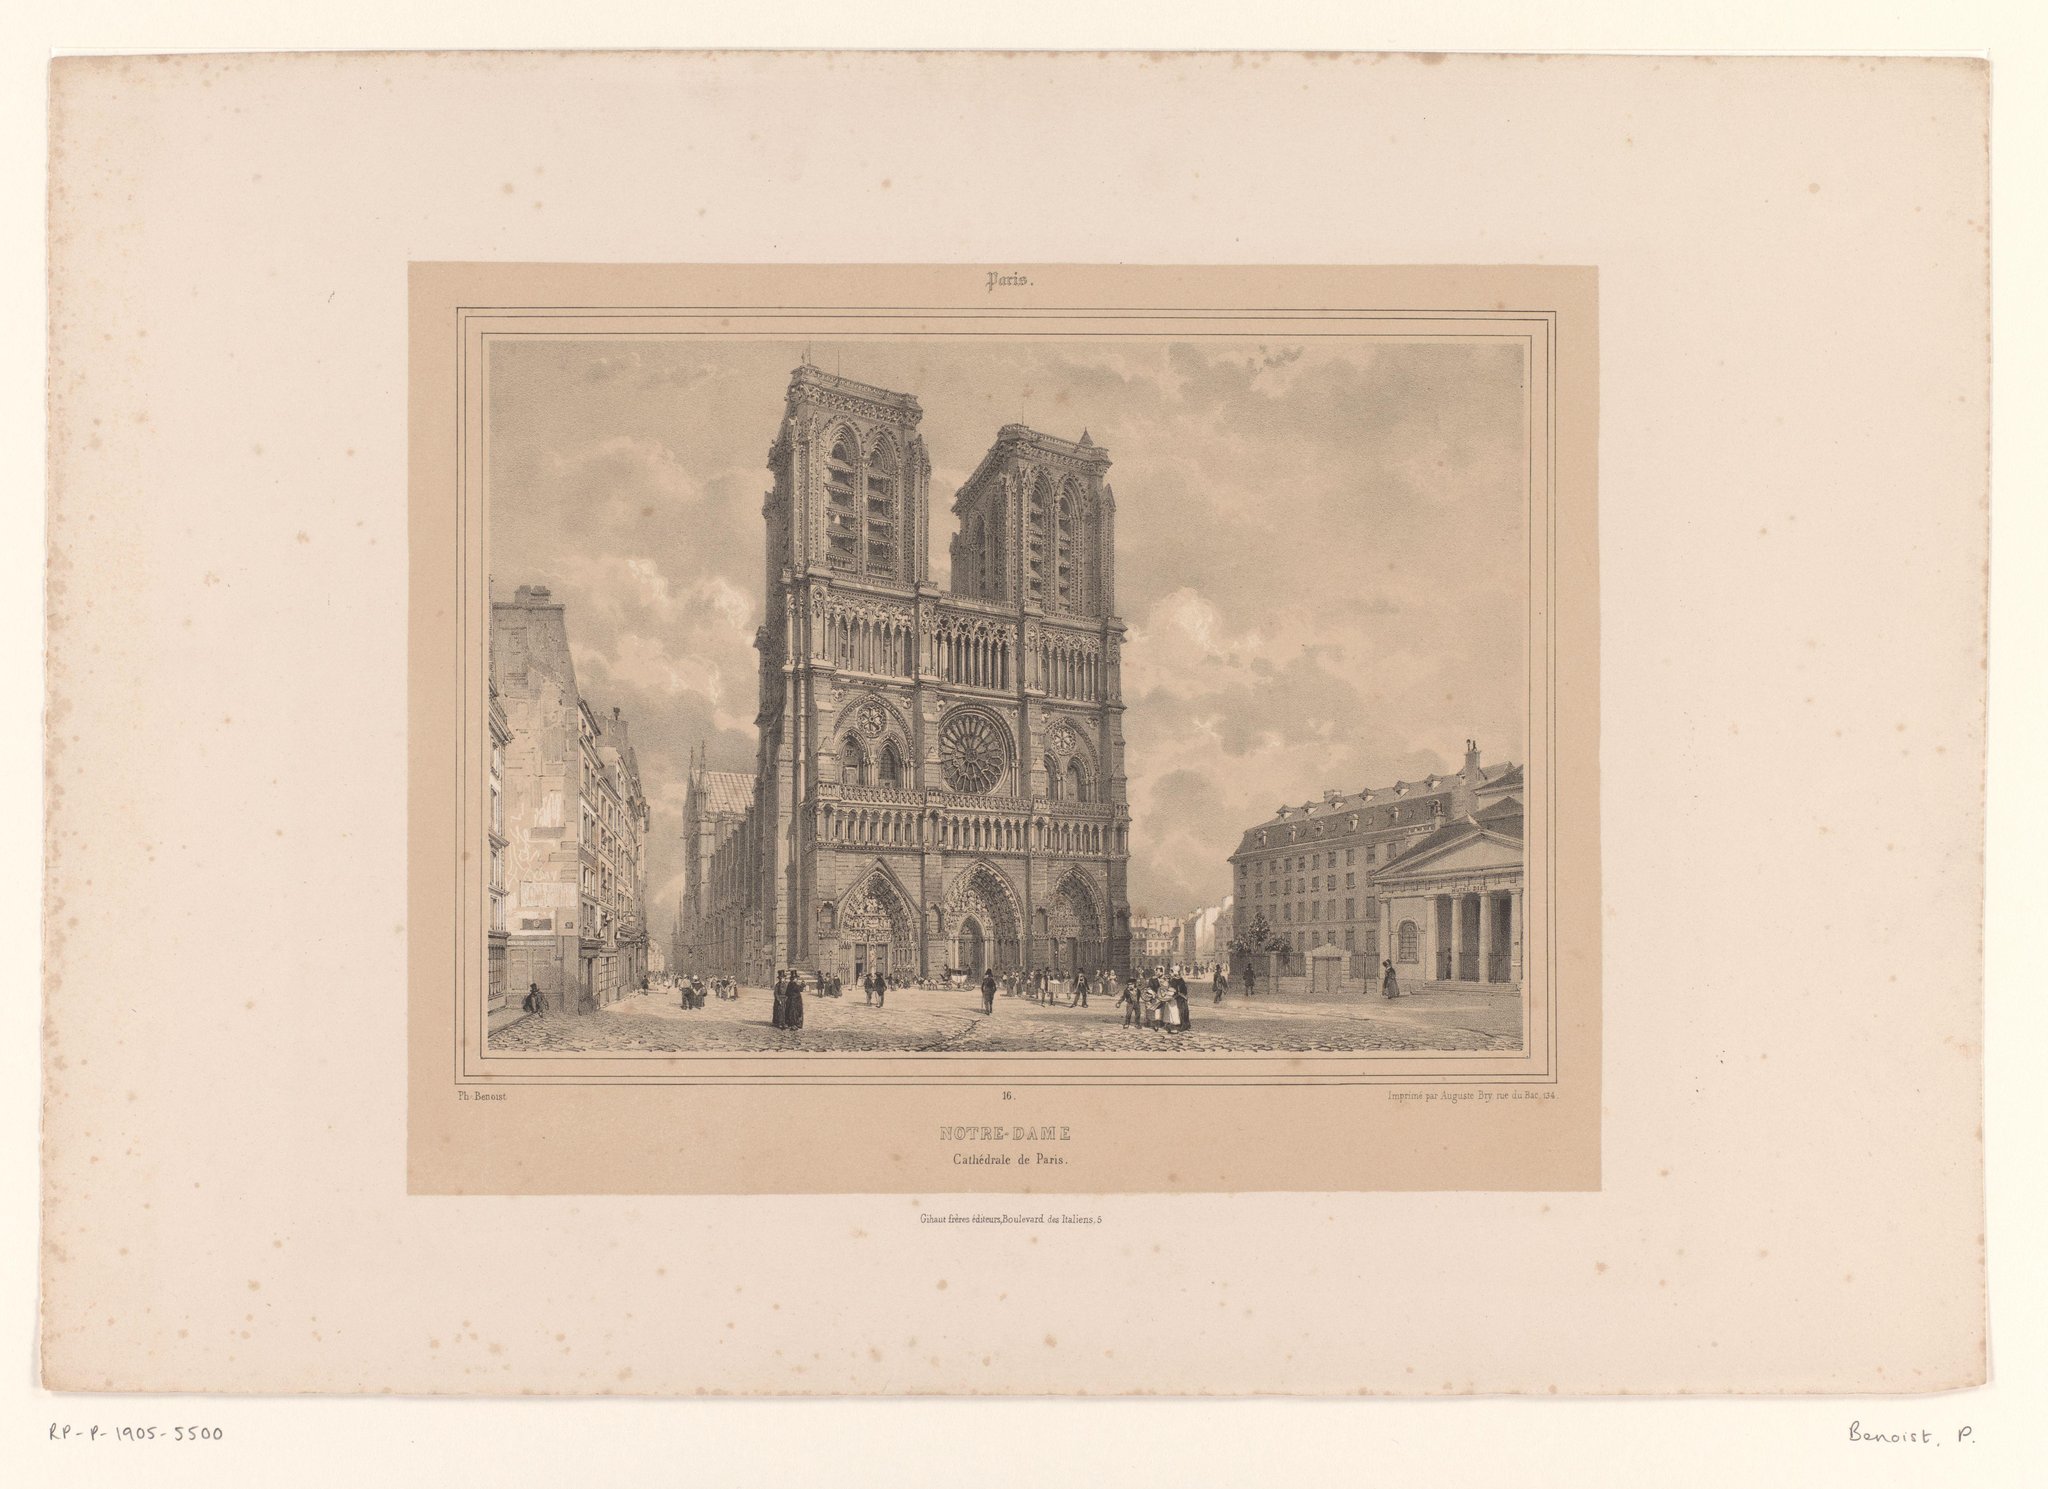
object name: print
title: Gezichten in Parijs en omgeving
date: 1843-1844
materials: paper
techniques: tone lithography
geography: paris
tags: church (exterior)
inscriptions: collector's mark: Lugt 2228a